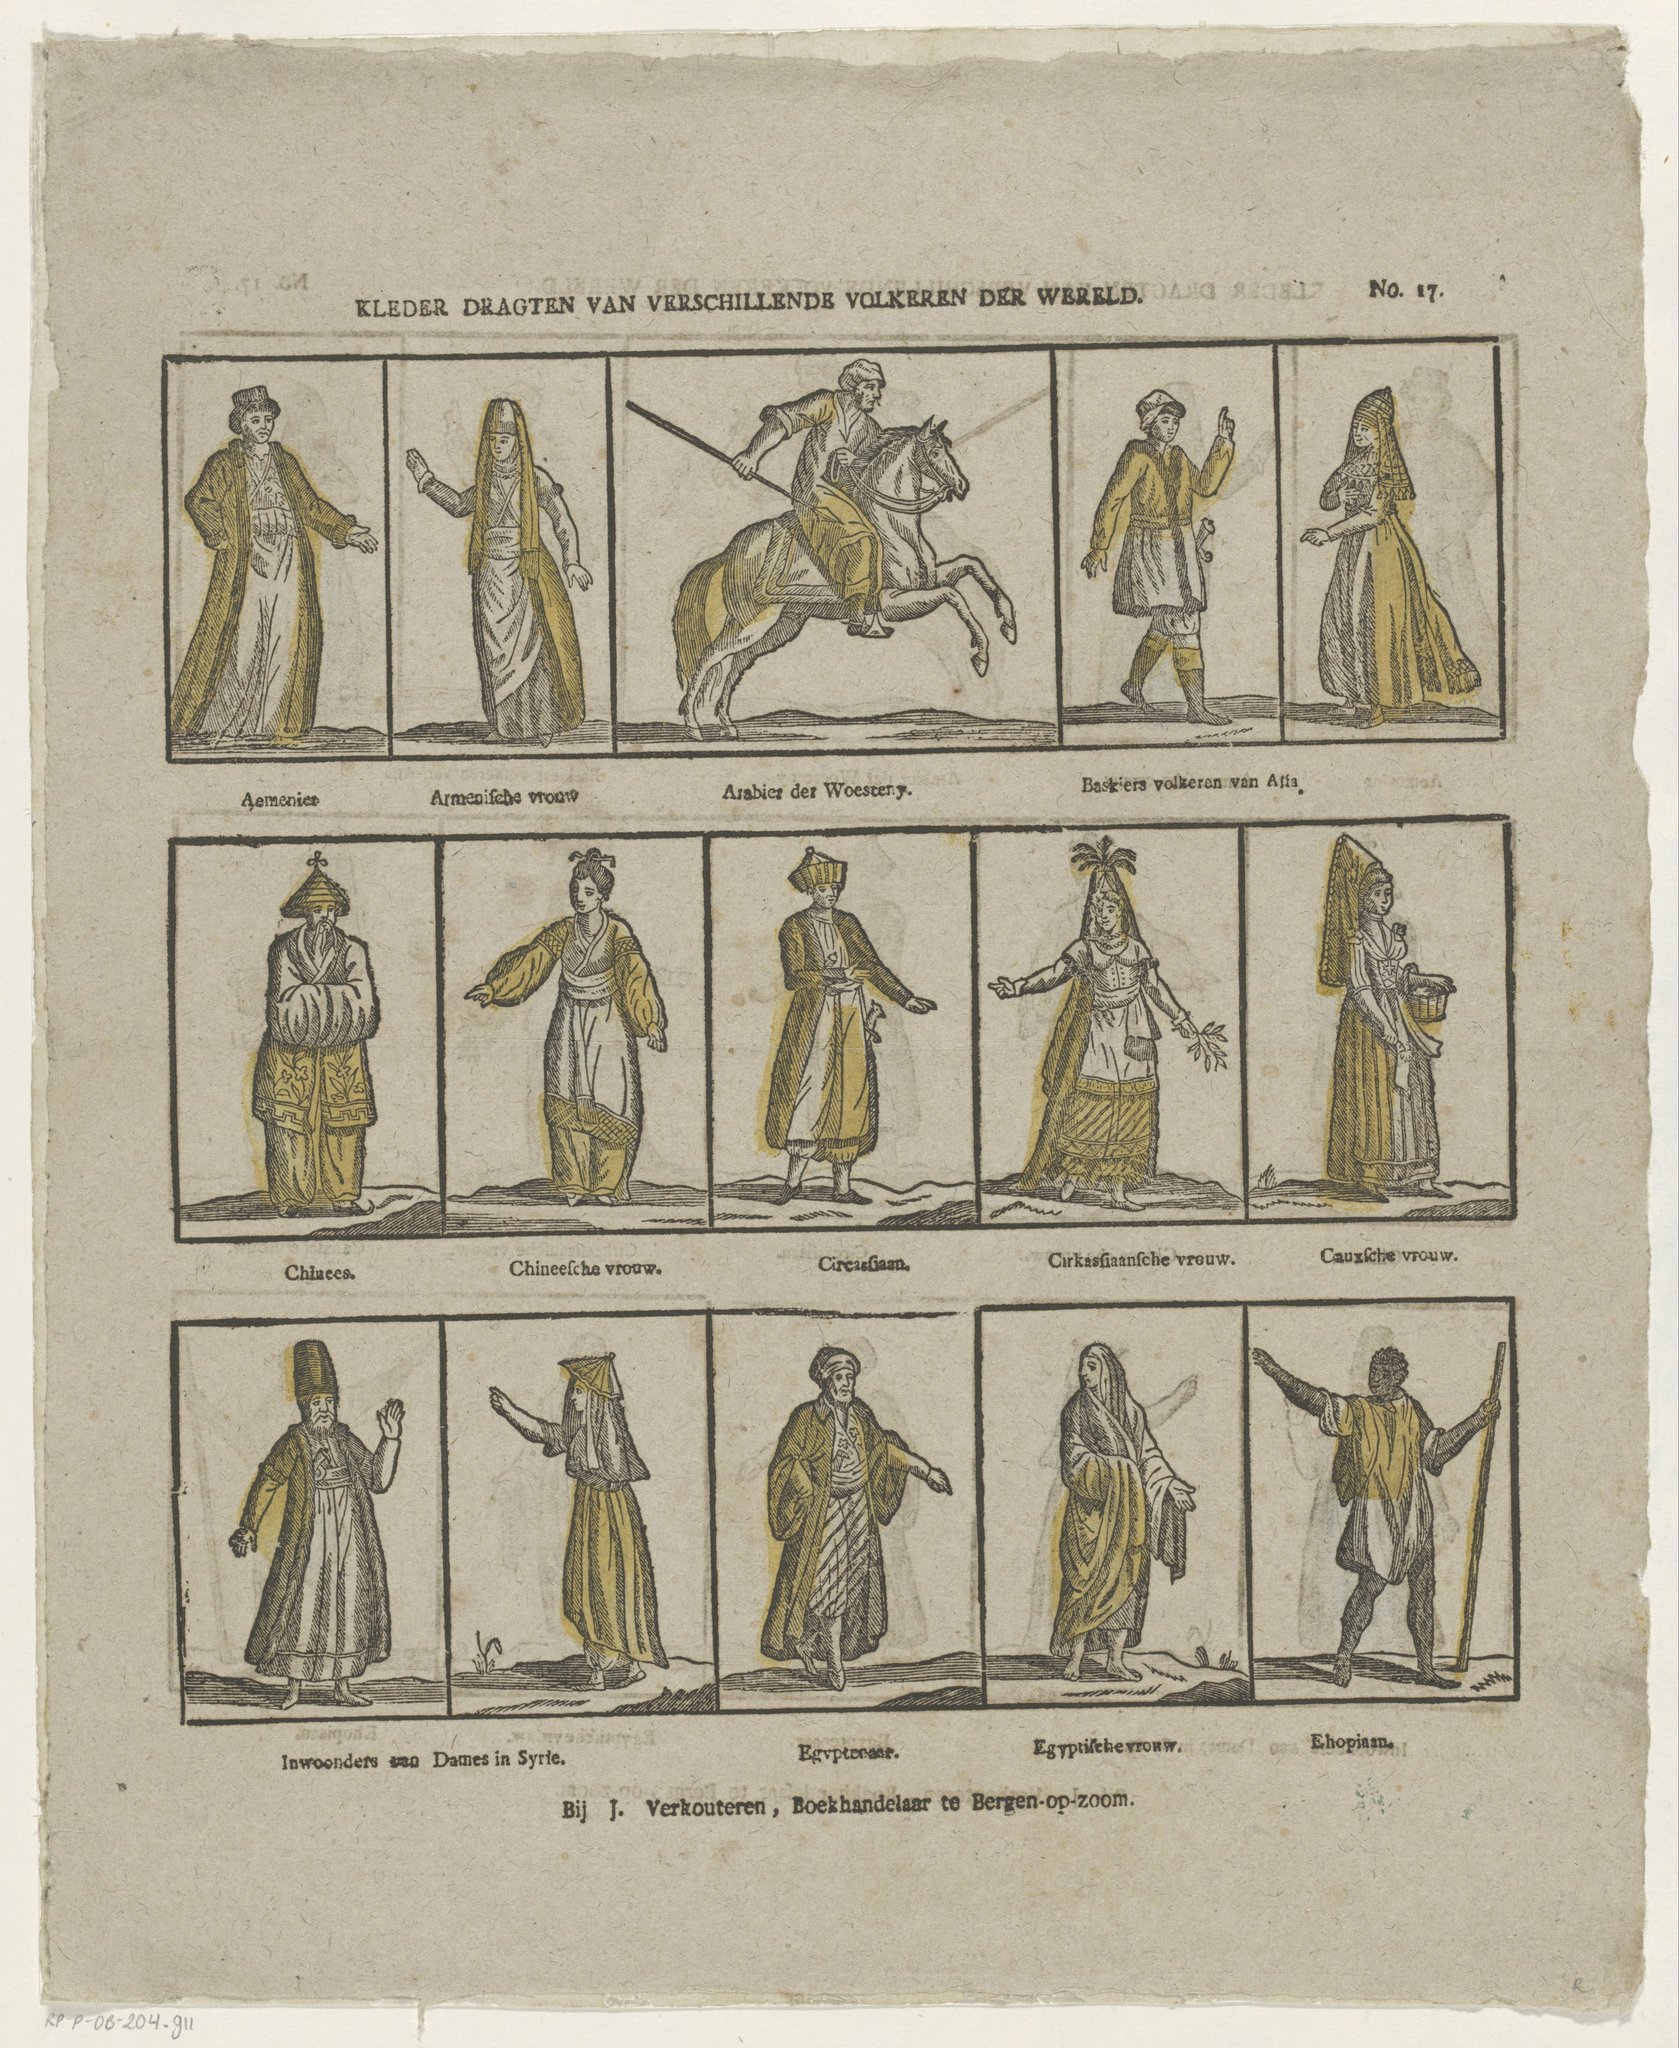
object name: popular print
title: kleder-dragten van verschillende volkeren der wereld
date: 1806-1830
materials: paper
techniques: colour, letterpress printing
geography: netherlands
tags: asiatic races and peoples, africans, historical costume, folk costume, regional costume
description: Blad met 3 houtsneden met elk vijf voorstellingen van klederdrachten van verschillende volkeren, waaronder klederdracht uit China en Egypte. Onder elke voorstelling een onderschrift. Genummerd rechtsboven: No. 17.